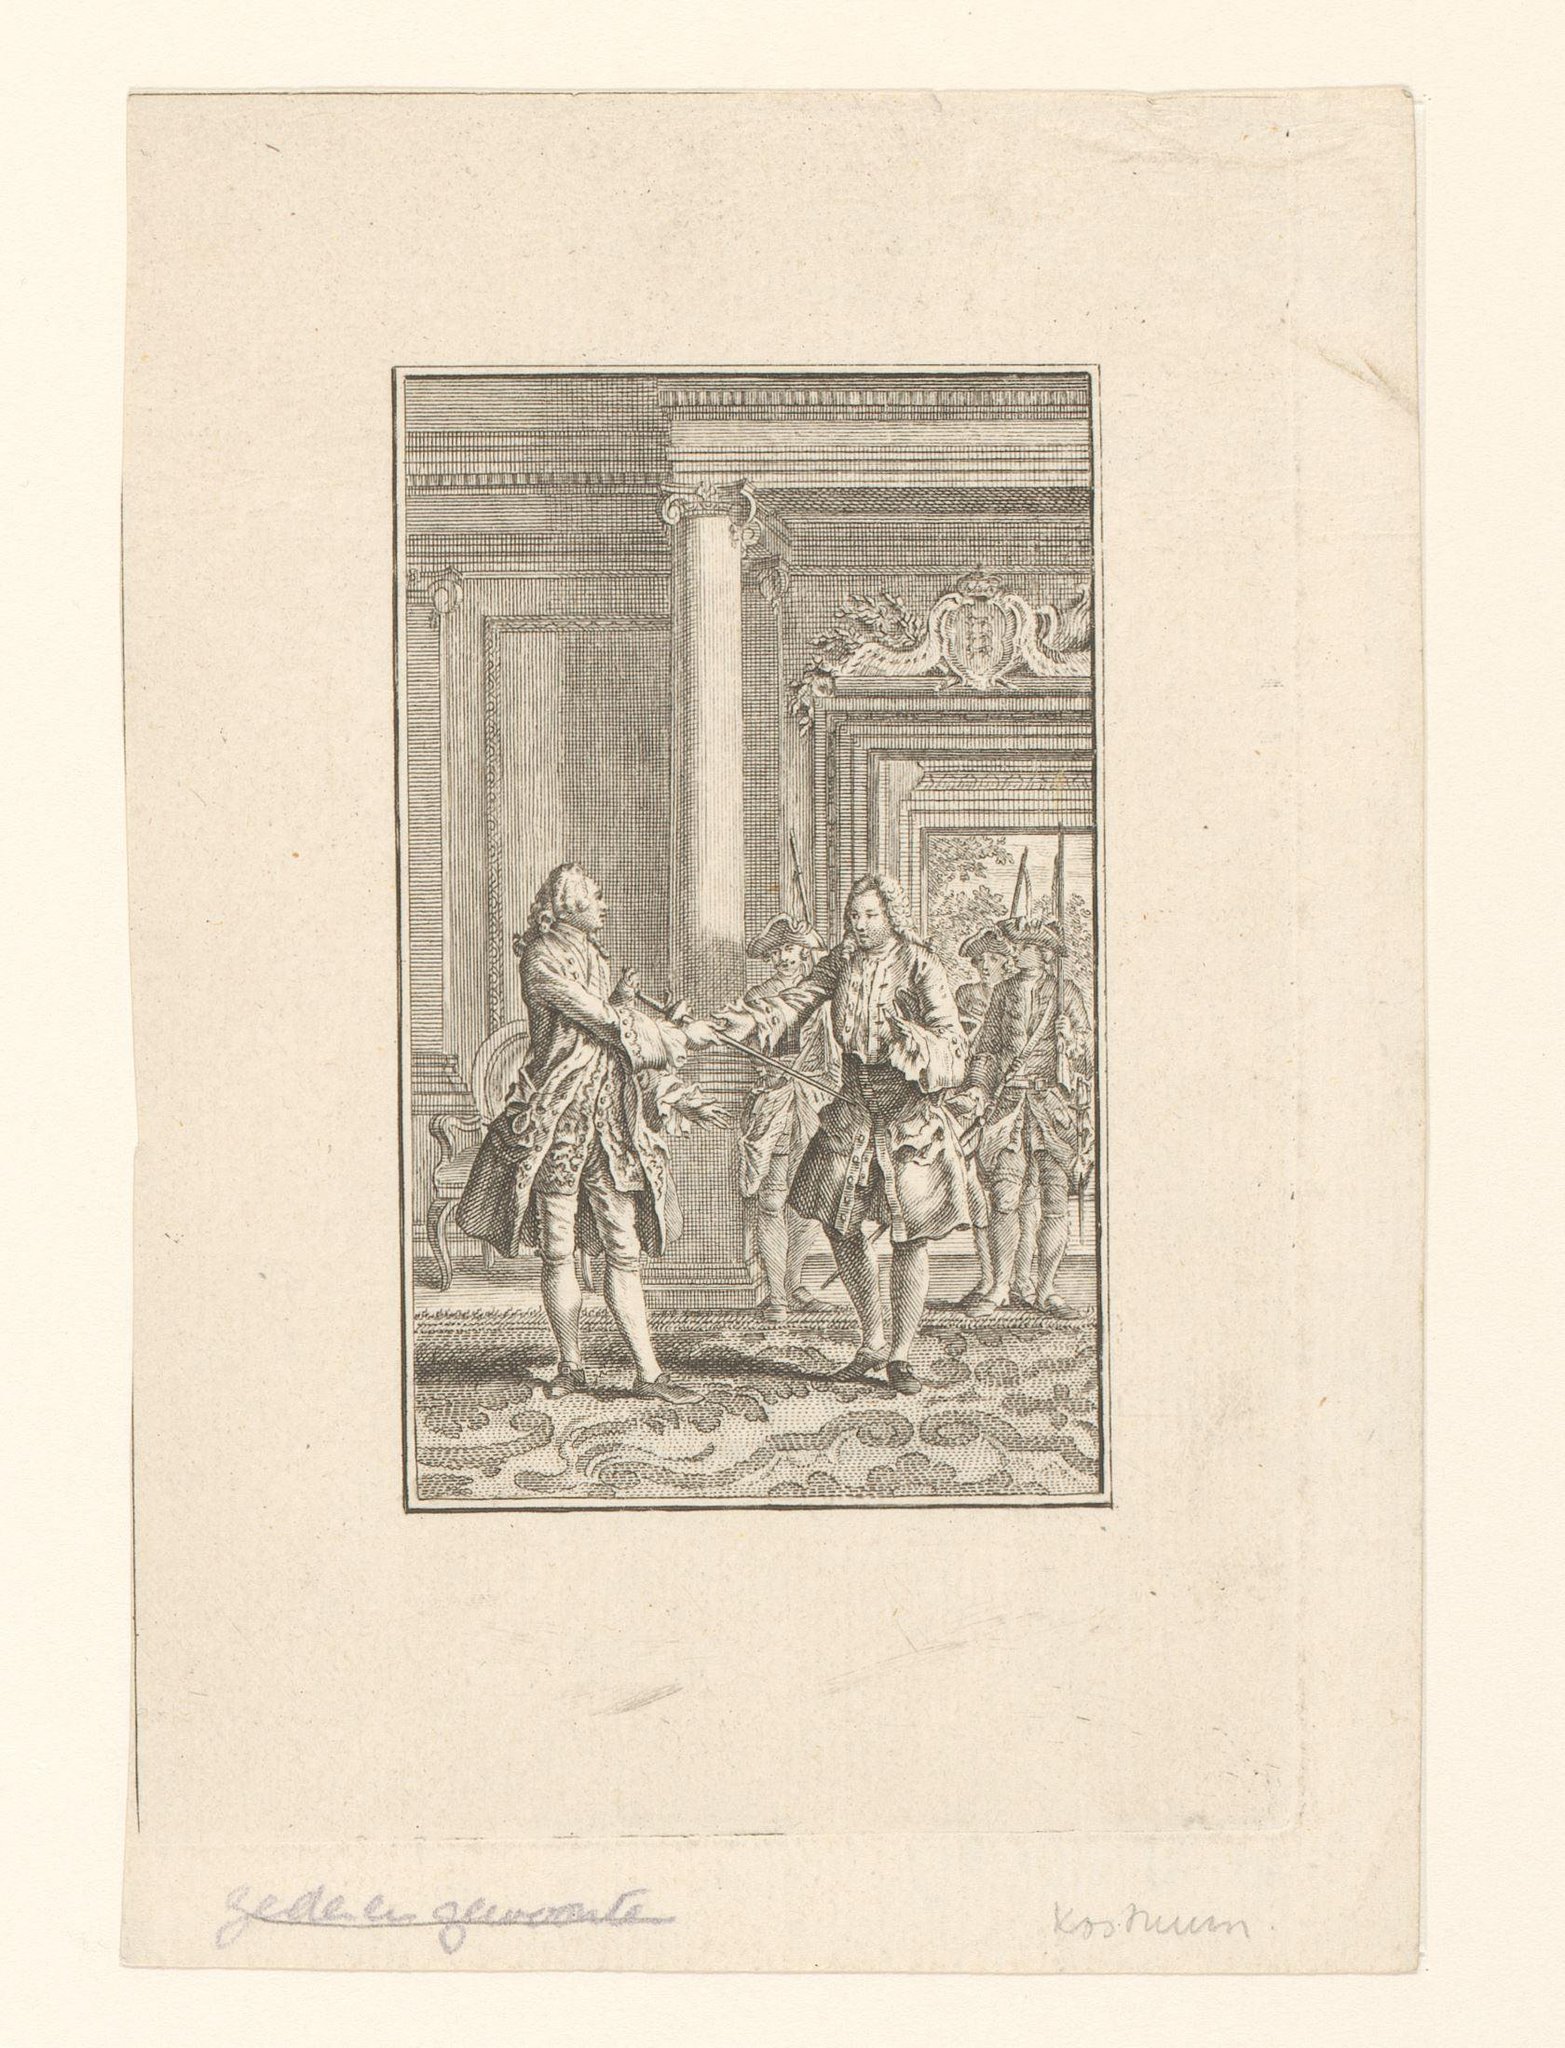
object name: print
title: Interieur met man die zijn degen overhandigt aan een andere man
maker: Anonymous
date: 1750-1800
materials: paper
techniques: etching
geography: france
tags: hacking and thrusting weapons: sword, the soldier; the soldier's life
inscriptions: collector's mark: Lugt 2228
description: Achter de tweede man staan drie soldaten.